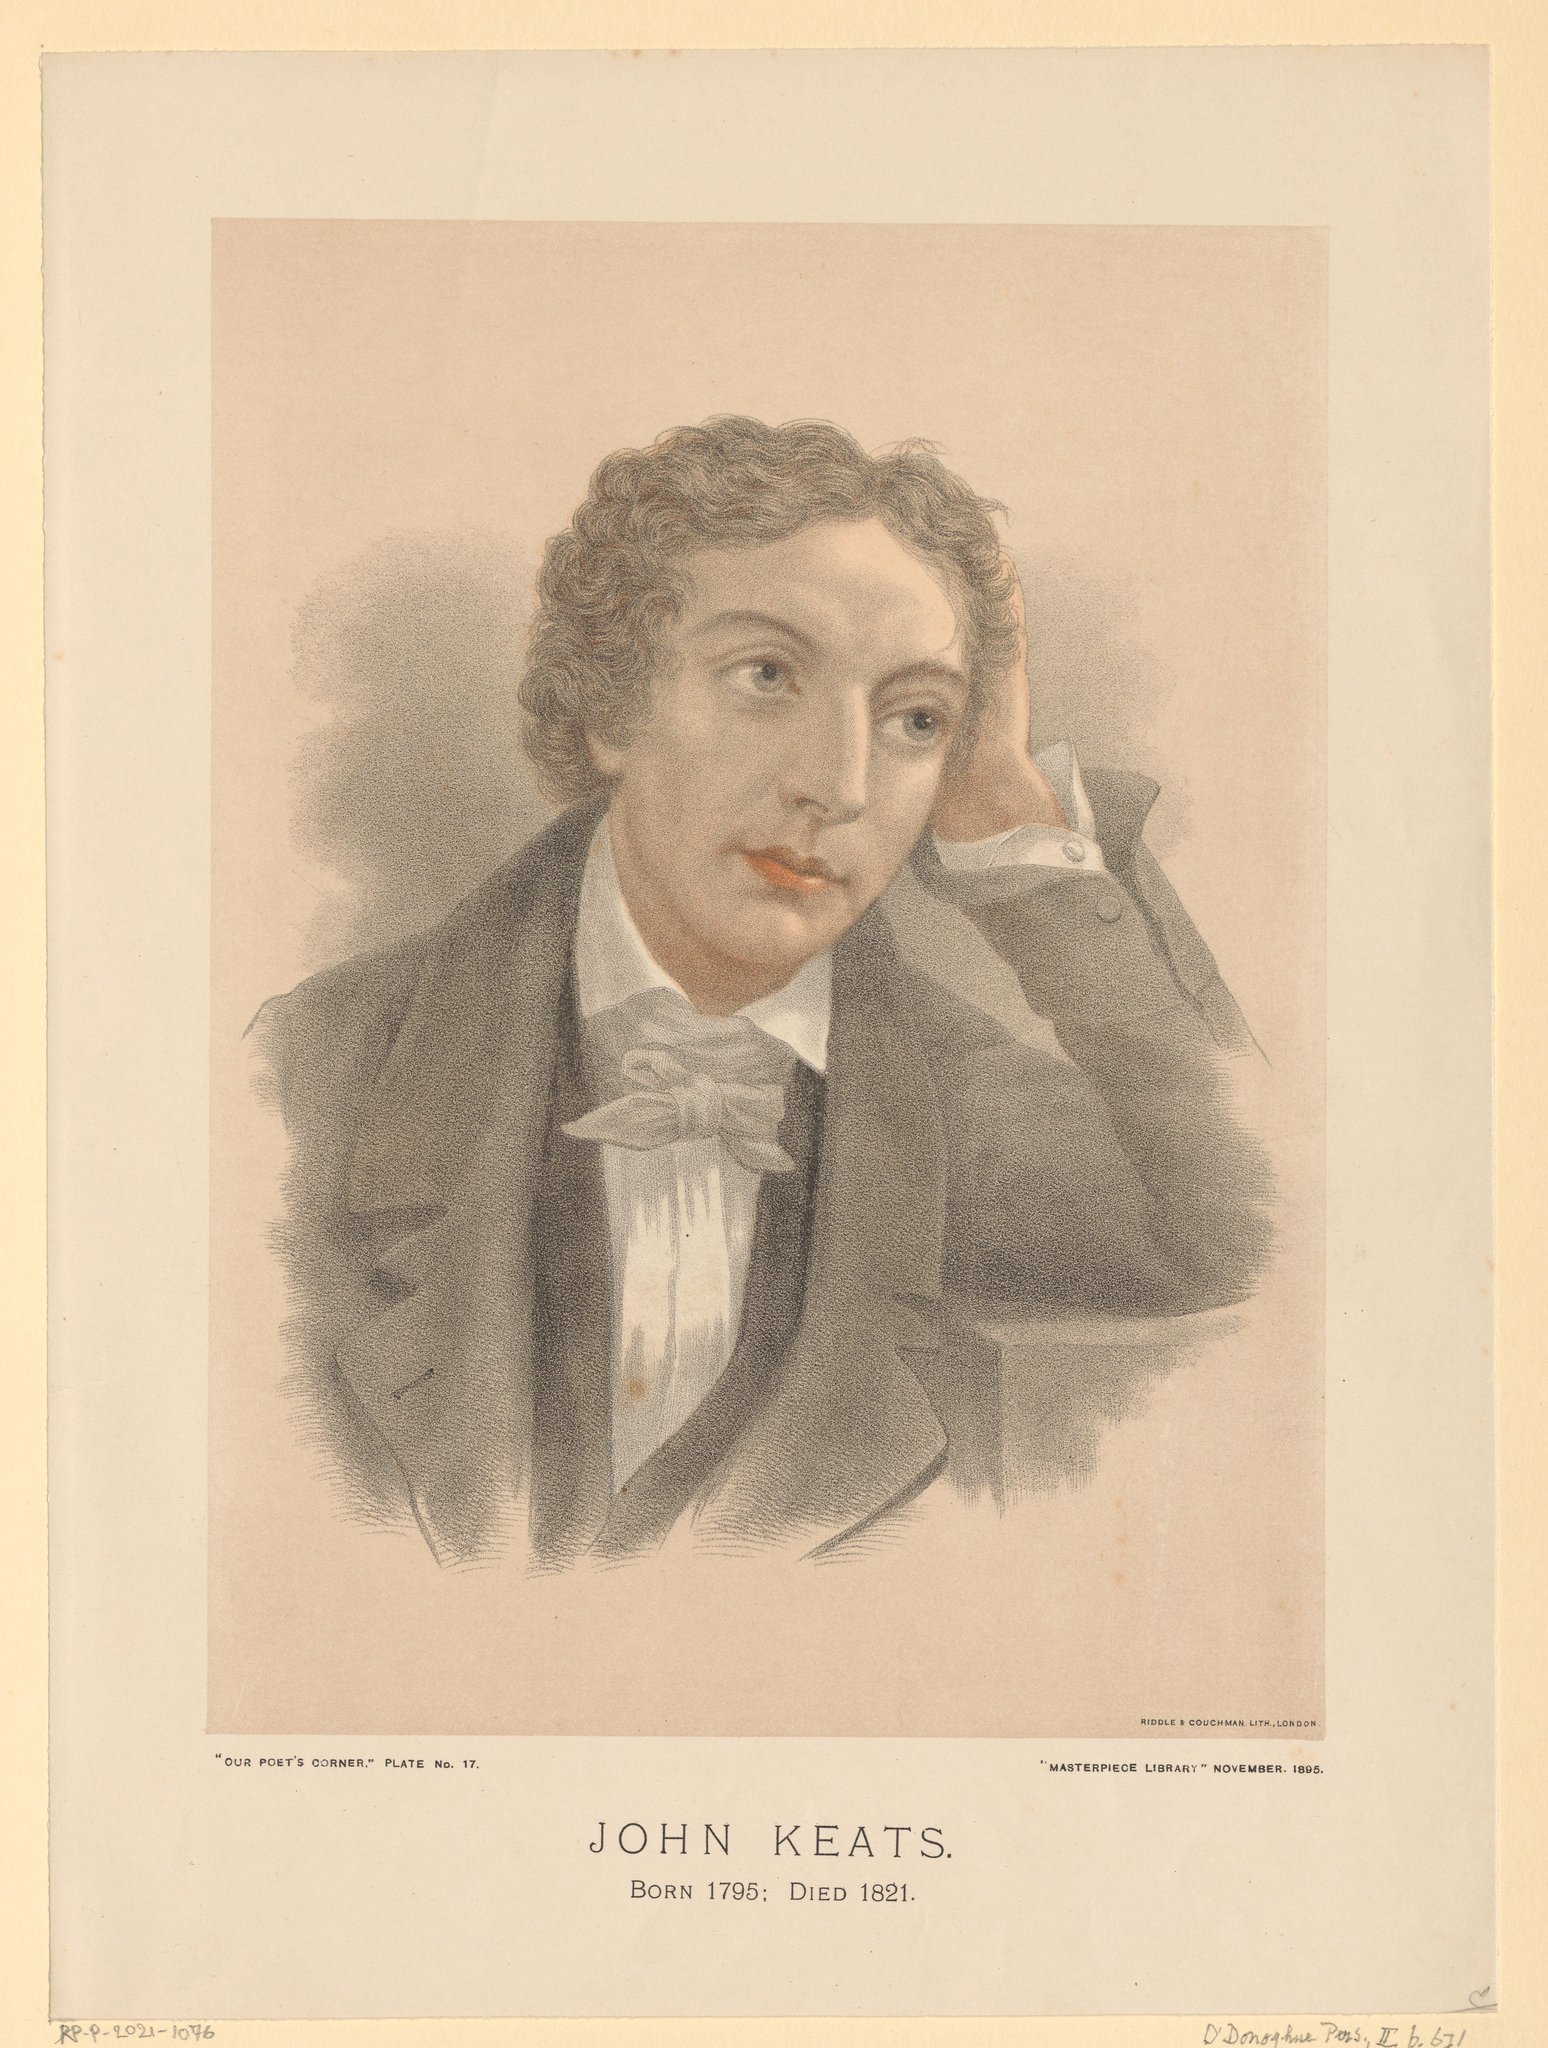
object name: print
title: Portretten van beroemde dichters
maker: Anonymous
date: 1895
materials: paper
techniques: lithograph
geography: london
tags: john keats, historical persons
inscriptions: date